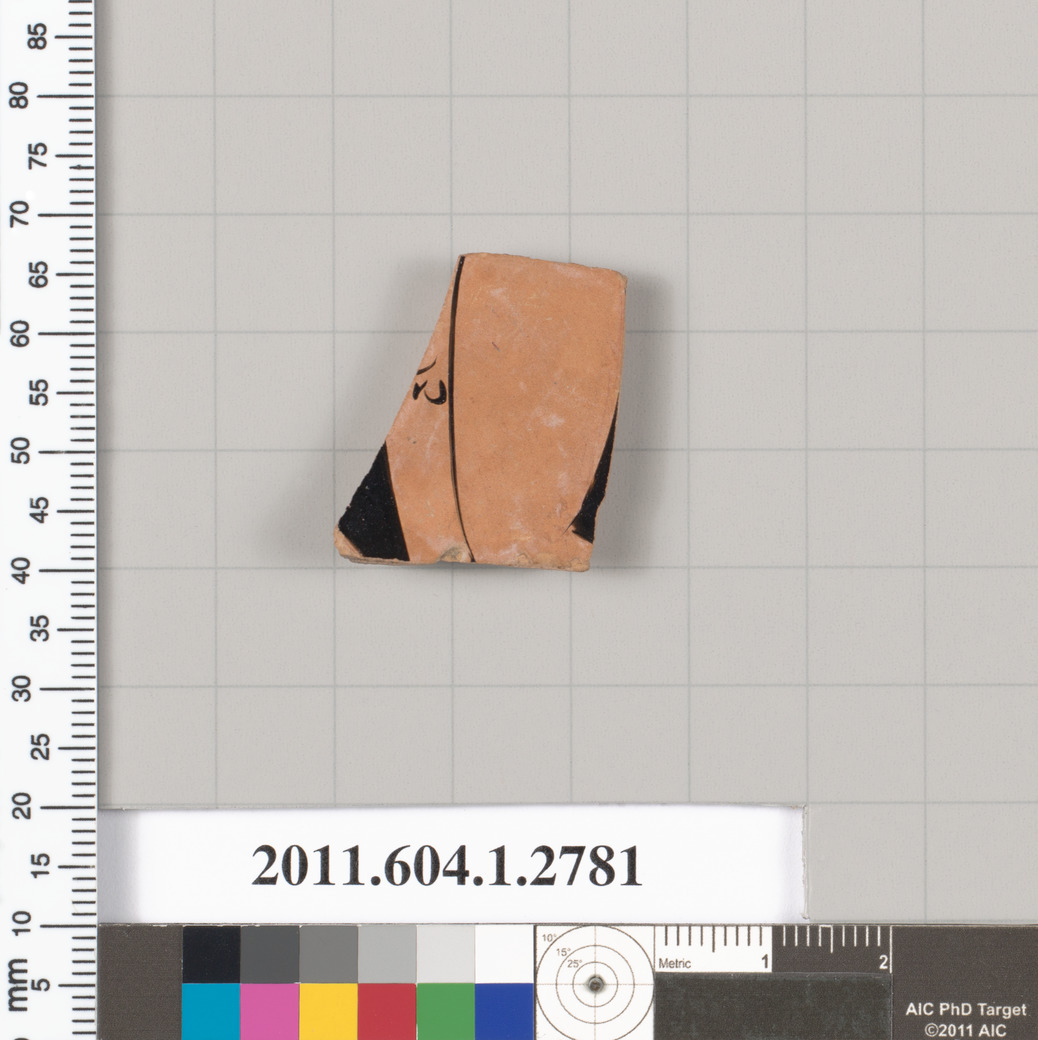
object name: kylix fragment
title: Terracotta fragment of a kylix (drinking cup)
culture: greek, attic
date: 460-450 BCE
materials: terracotta